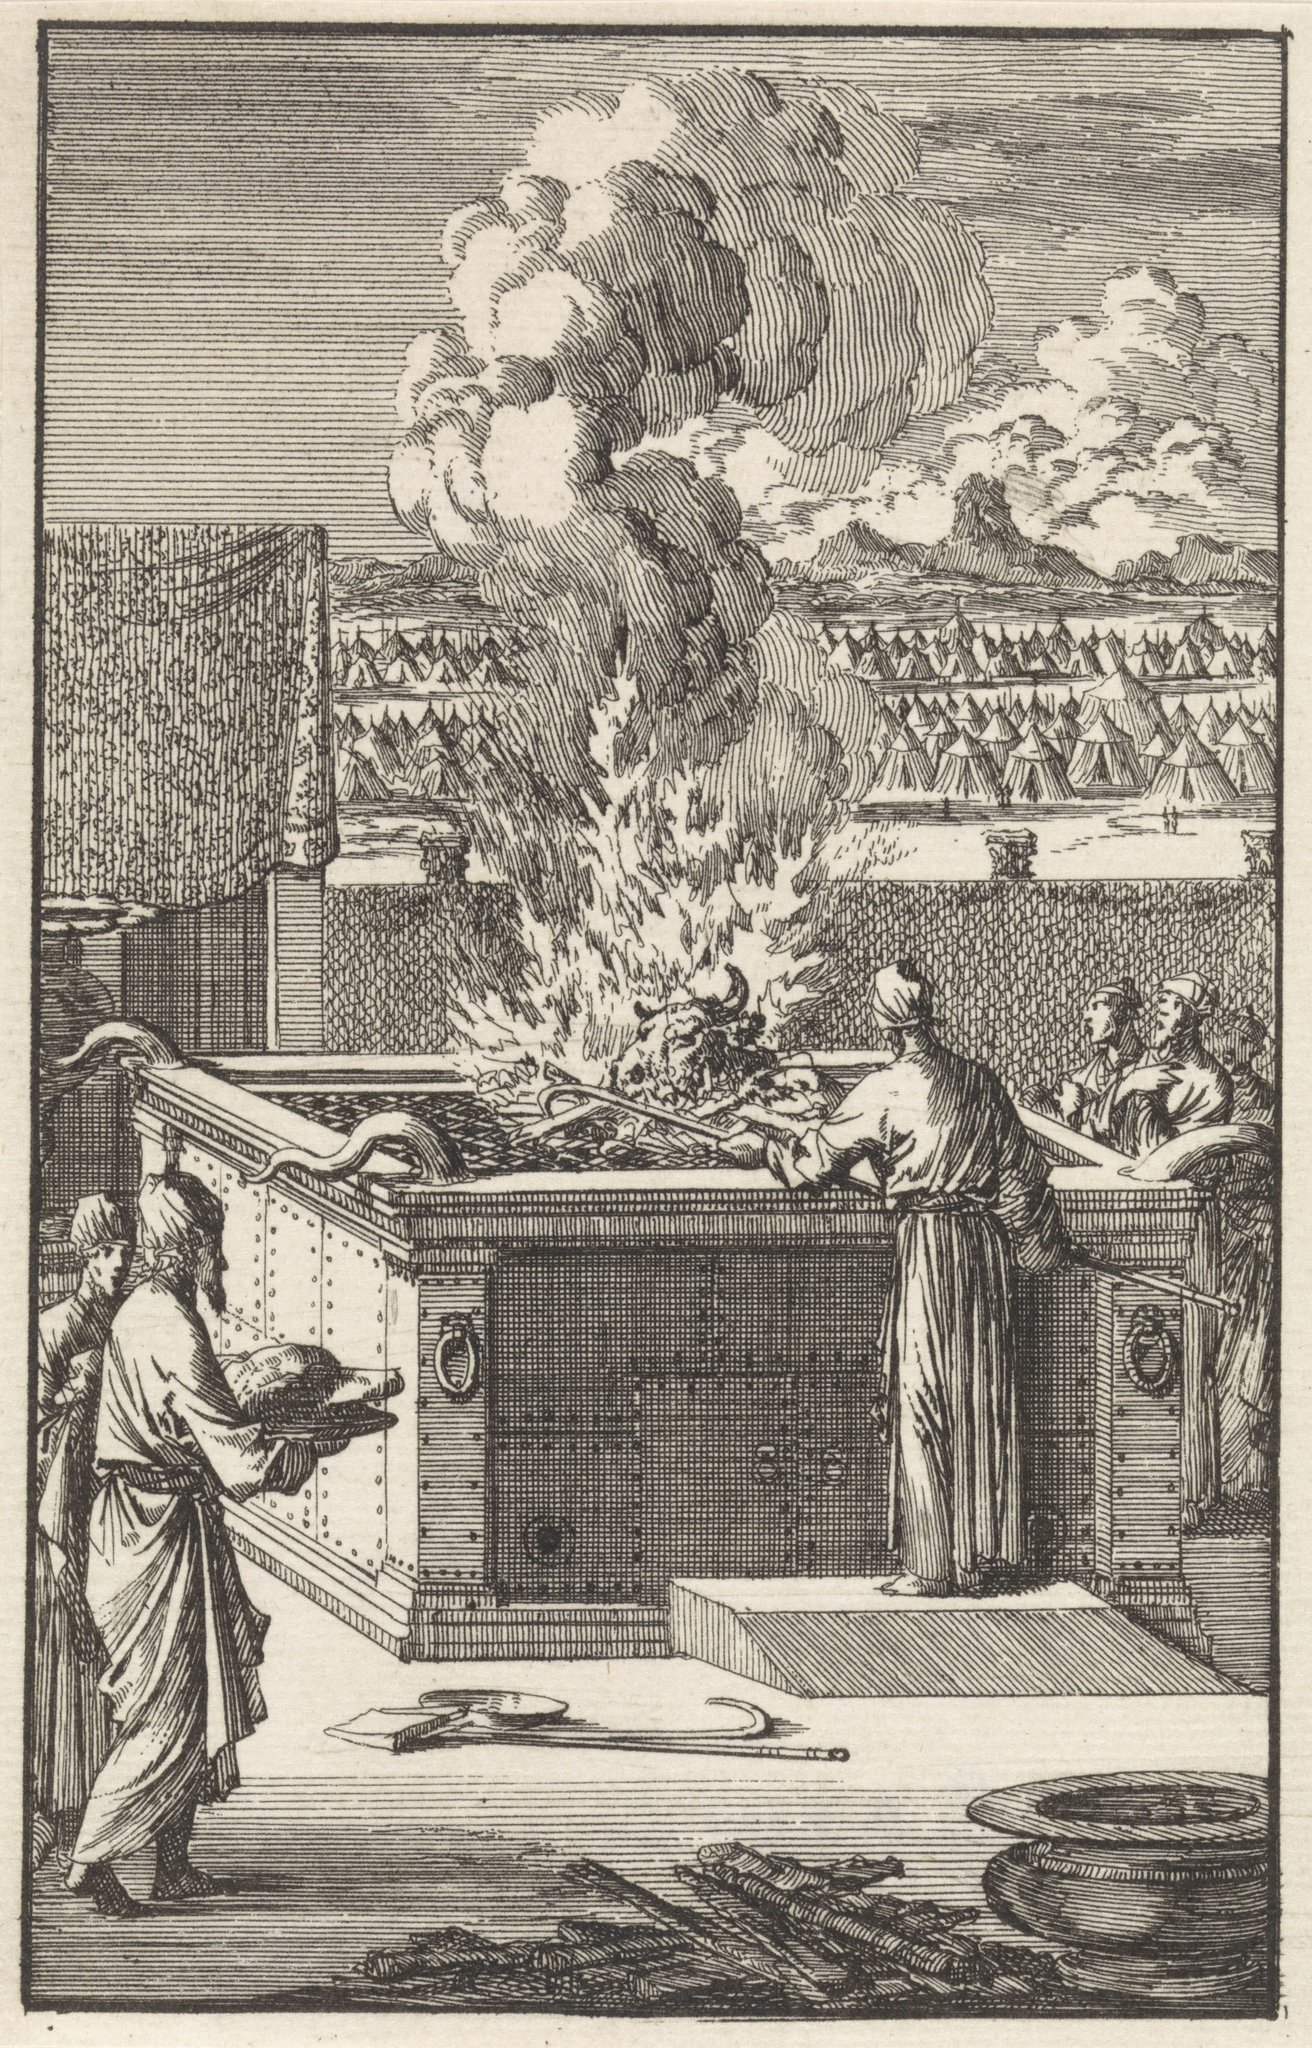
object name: print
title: Priester offert stier op het brandofferaltaar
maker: jan luyken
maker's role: draughtsman, print maker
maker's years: 1649-1712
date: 1705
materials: paper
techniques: etching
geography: amsterdam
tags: the altar of burnt offering, the brazen altar ~ jewish religion, the court of the tabernacle ~ jewish religion, sacrifice of animals ~ jewish religion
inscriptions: collector's mark: Lugt 2228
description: Proefdruk van illustratie uit: Cunaeus, Petrus. La republique des Hebreux, 3 delen. Amsterdam: Pieter Mortier, 1705, dl. II, p. 257.